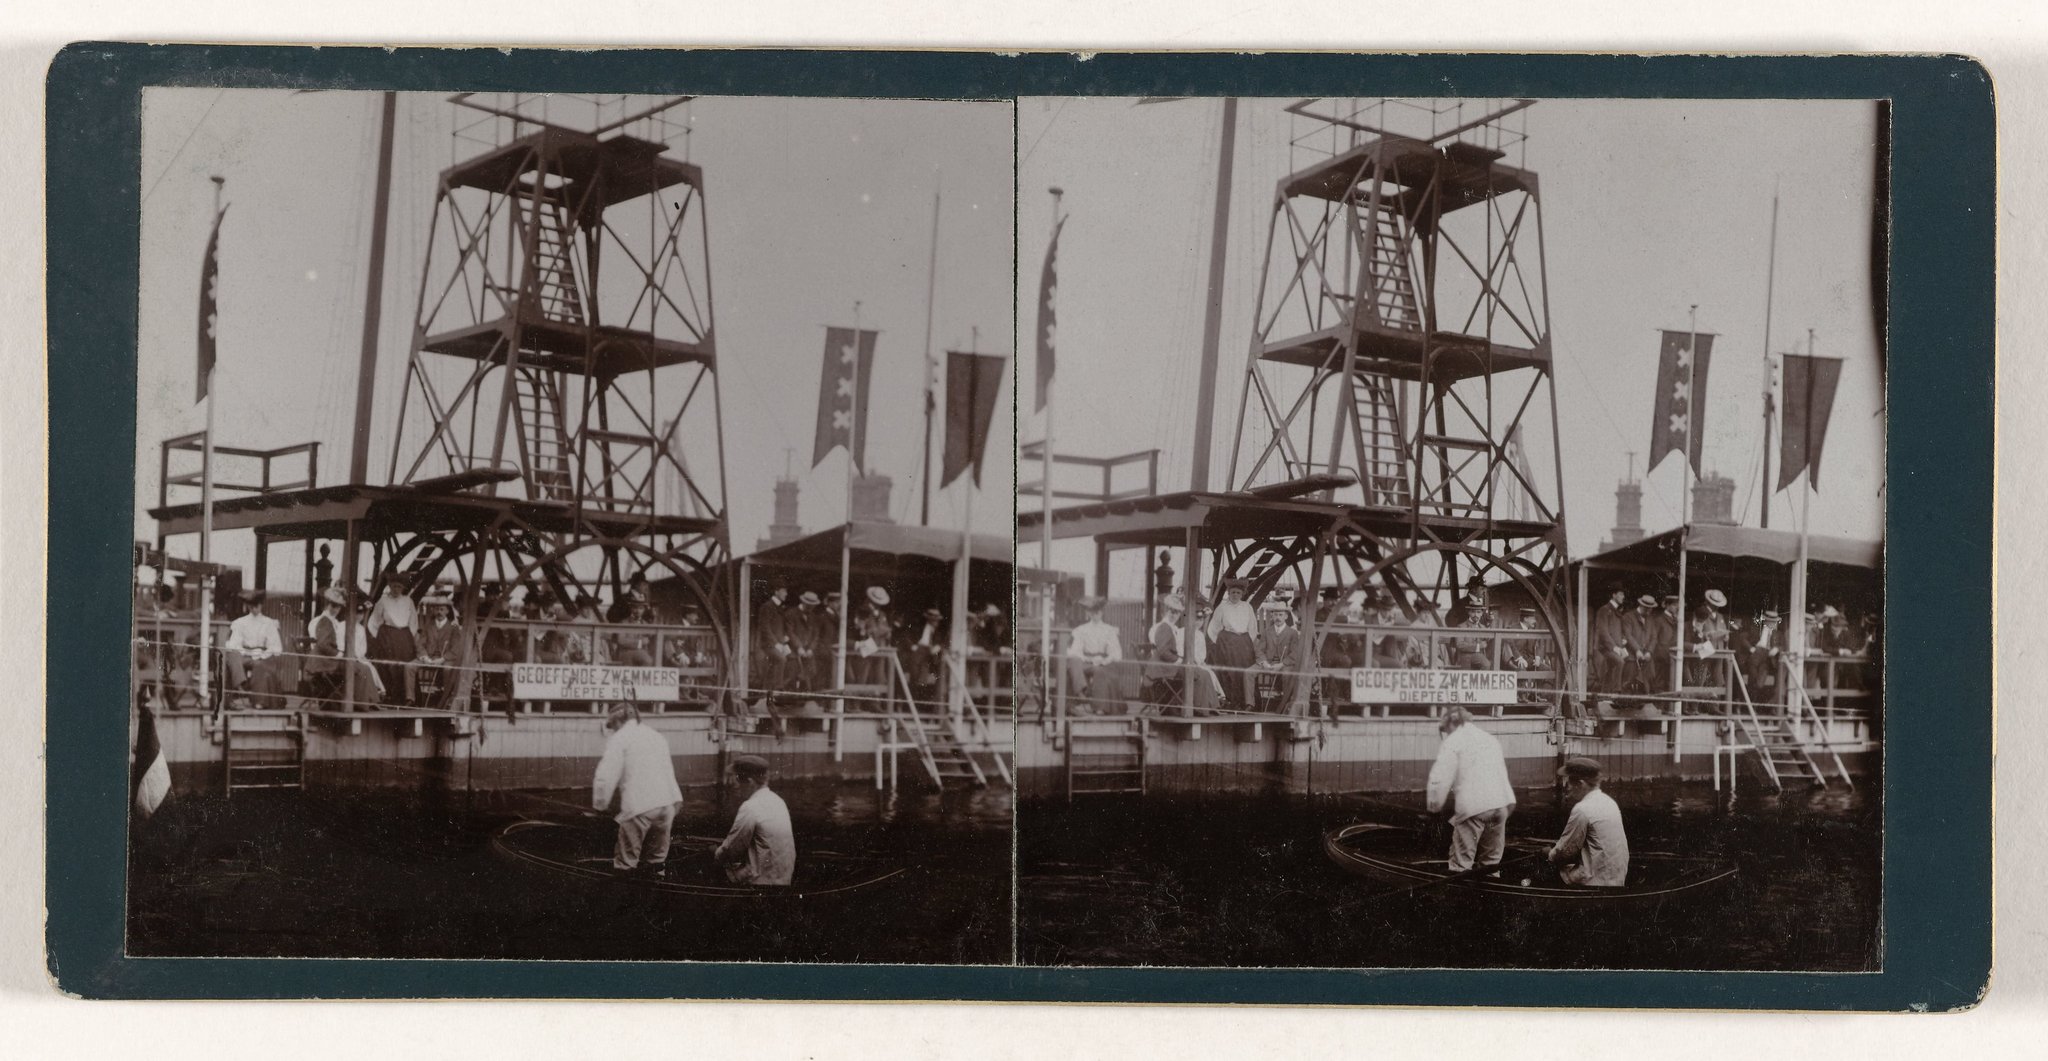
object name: stereograph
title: Roeiboot in een buitenbad in Amsterdam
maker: Anonymous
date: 1880-1910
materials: paper, cardboard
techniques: collodion silver print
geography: amsterdam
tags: rowing-boat, canoe, etc.